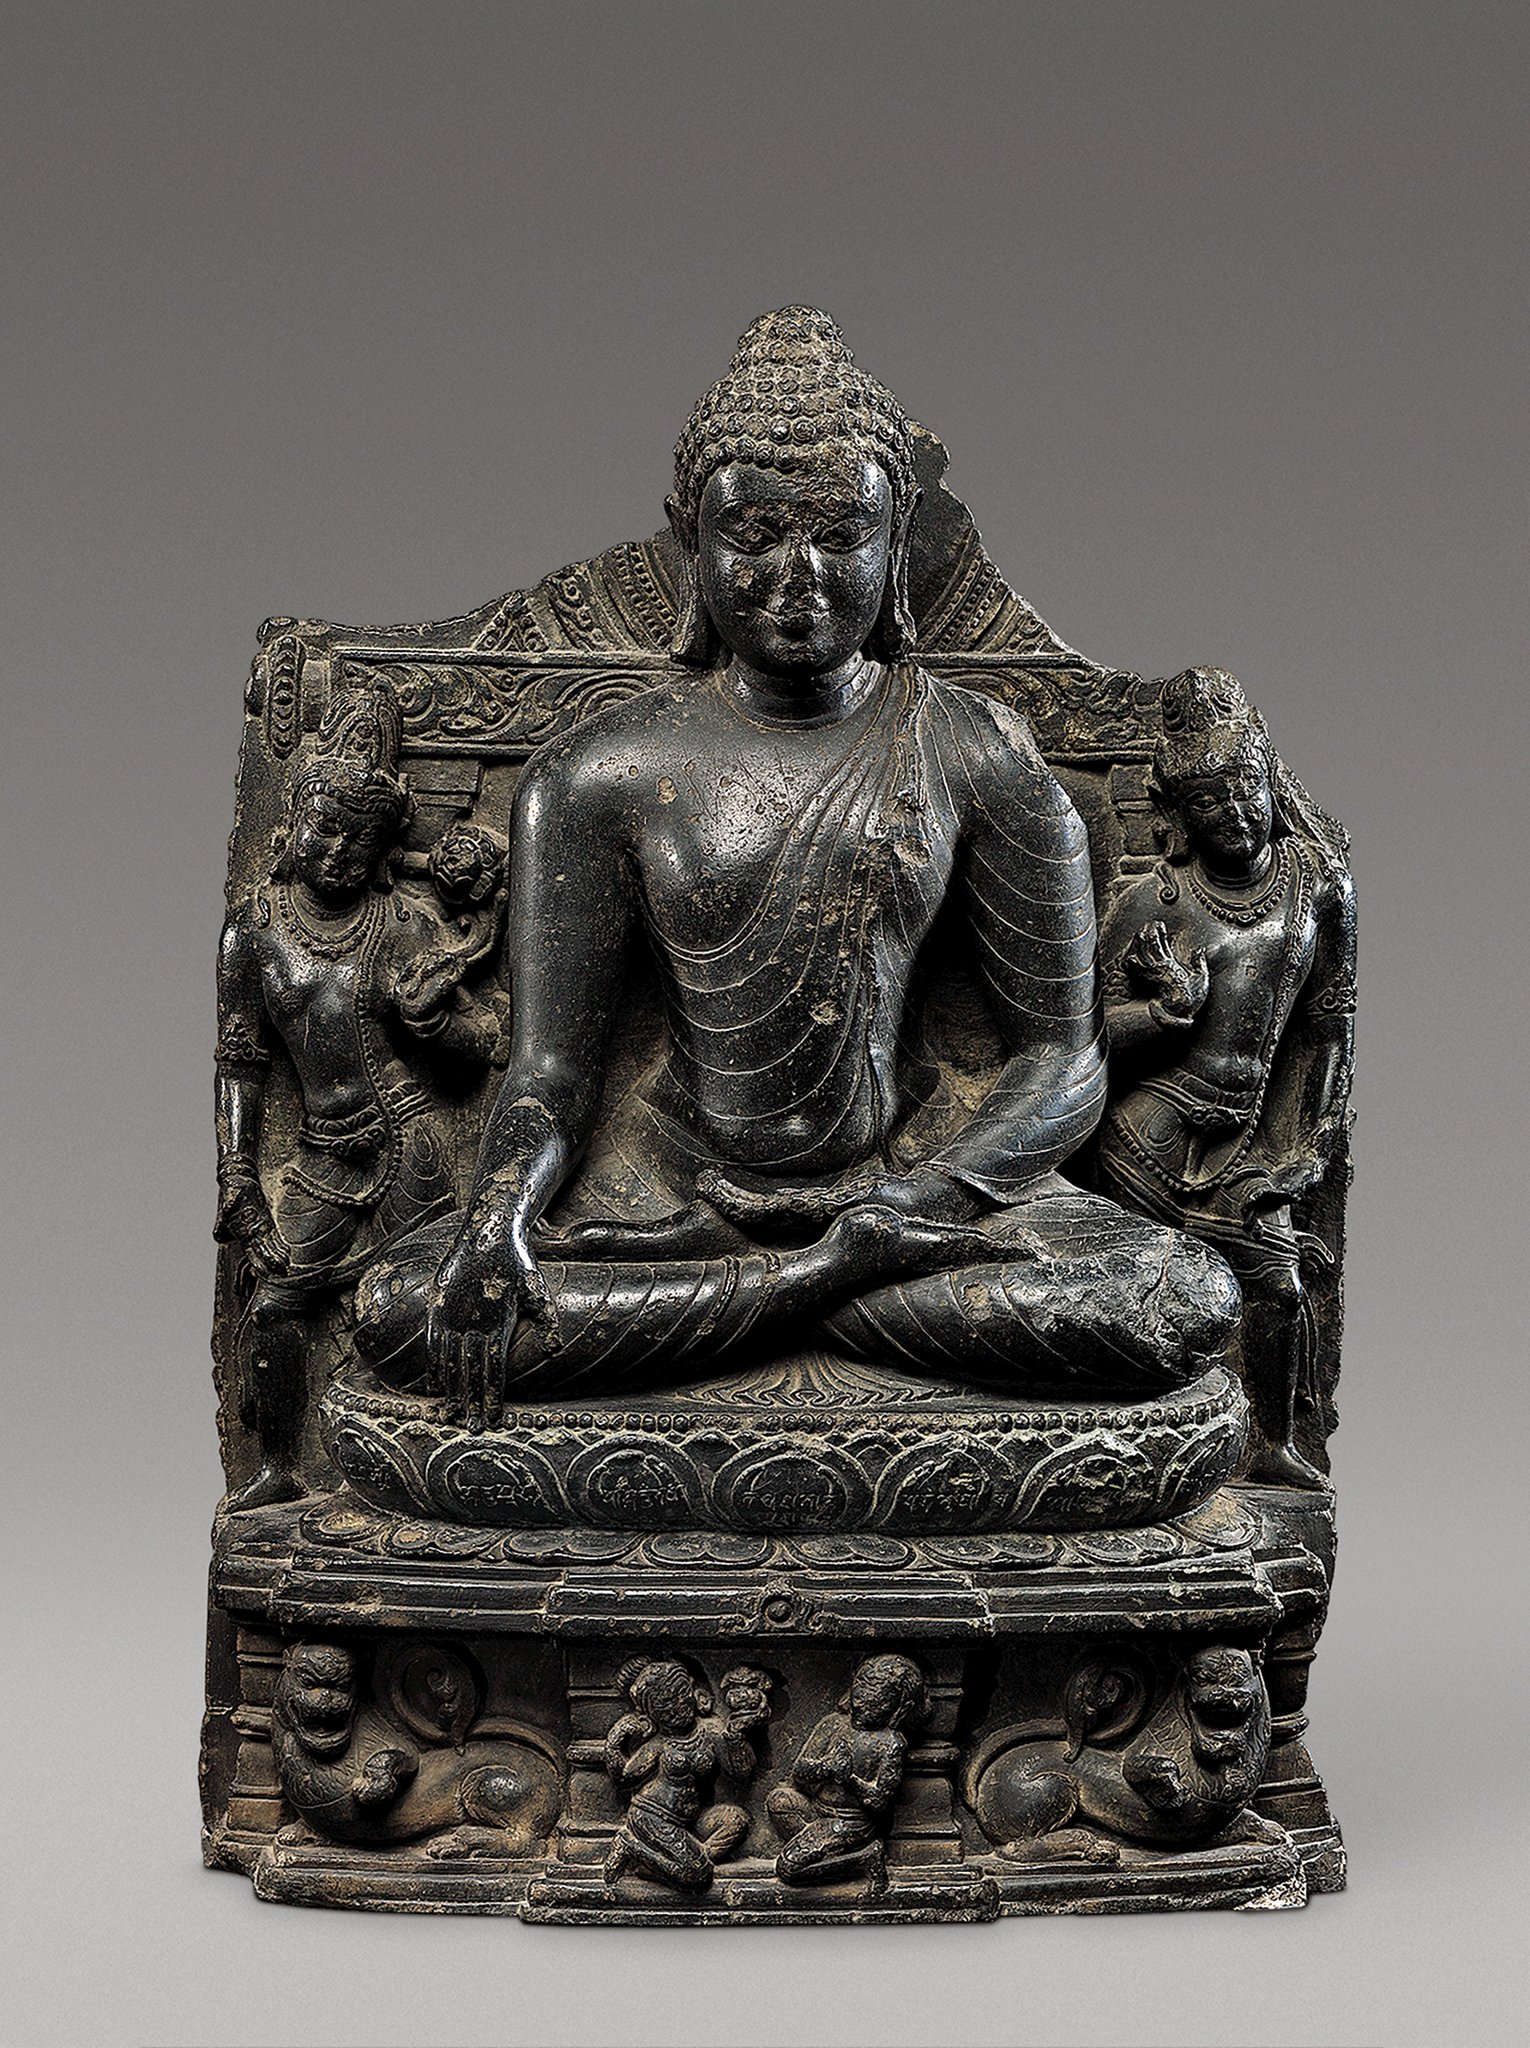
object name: stele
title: Seated Buddha Reaching Enlightenment, Flanked by Avalokiteshvara and Maitreya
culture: indian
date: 967-1100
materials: stone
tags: buddhism,avalokiteshvara,buddha,maitreya